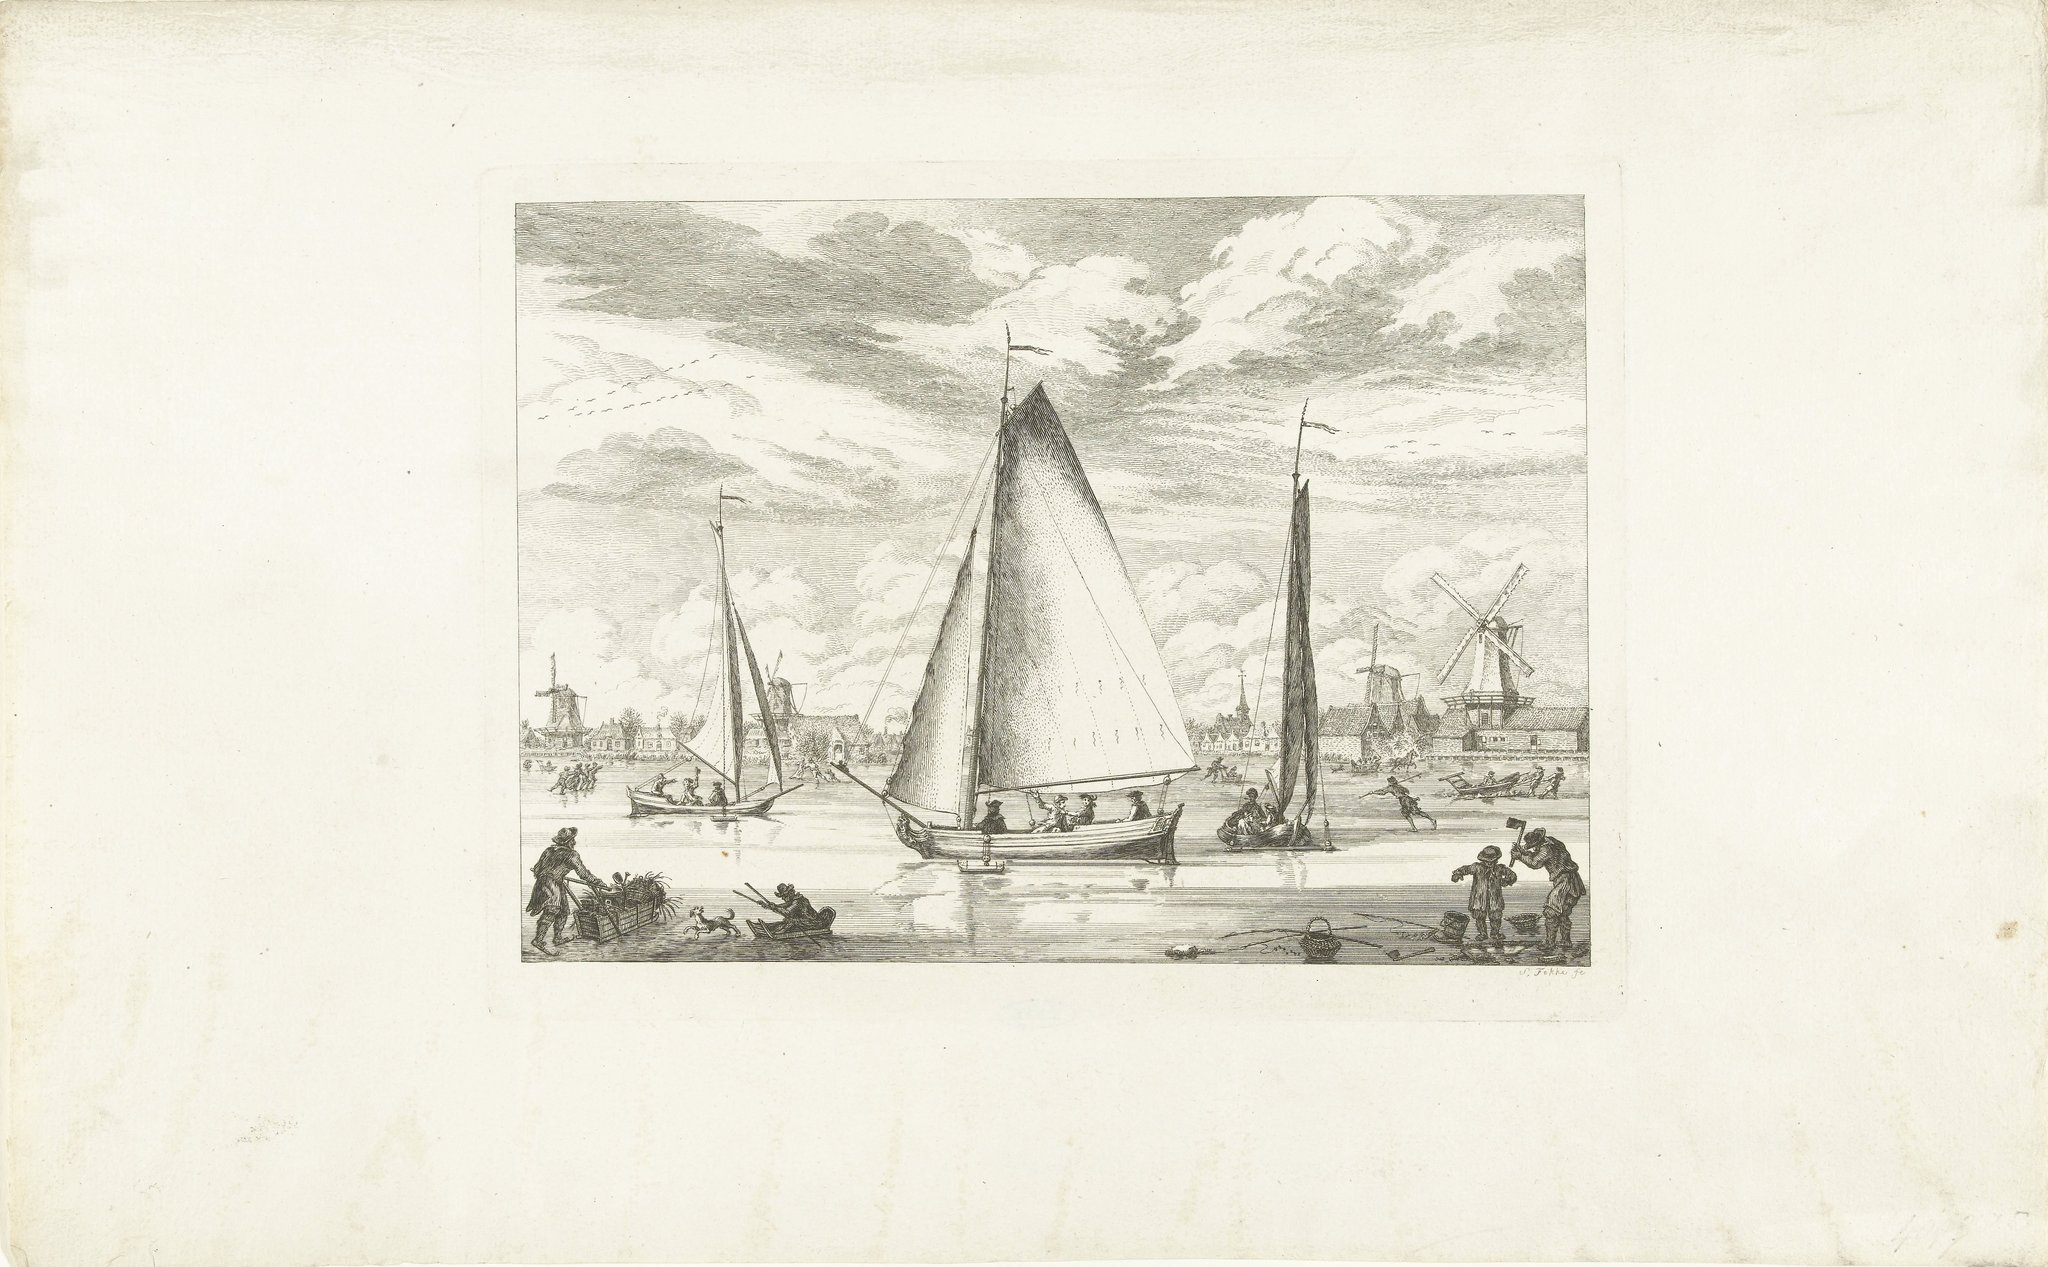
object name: print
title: Hollandse ijsschuitjes met op de achtergrond Koog aan de Zaan, ca. 1775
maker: simon fokke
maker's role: draughtsman, print maker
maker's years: 1712-1784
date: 1774-1776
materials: paper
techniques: etching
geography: northern netherlands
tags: ice-sailing (winter sports), winter sports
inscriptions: collector's mark: Lugt 2228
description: Wintergezicht met Hollandse ijsschuitjes. IJszeilen, sledes en schaatsers op de bevroren Zaan, op de achtergrond molens en huizen van Koog aan de Zaan, ca. 1775. De molens zijn van links naar rechts: oliemolen De Reus, loodwitmolen De Rob, pelmolen De Pelikaan en oliemolen De Christoffel of Broodkorf. Deze laatste twee molens stonden op de zogenaamde Koger Hem.